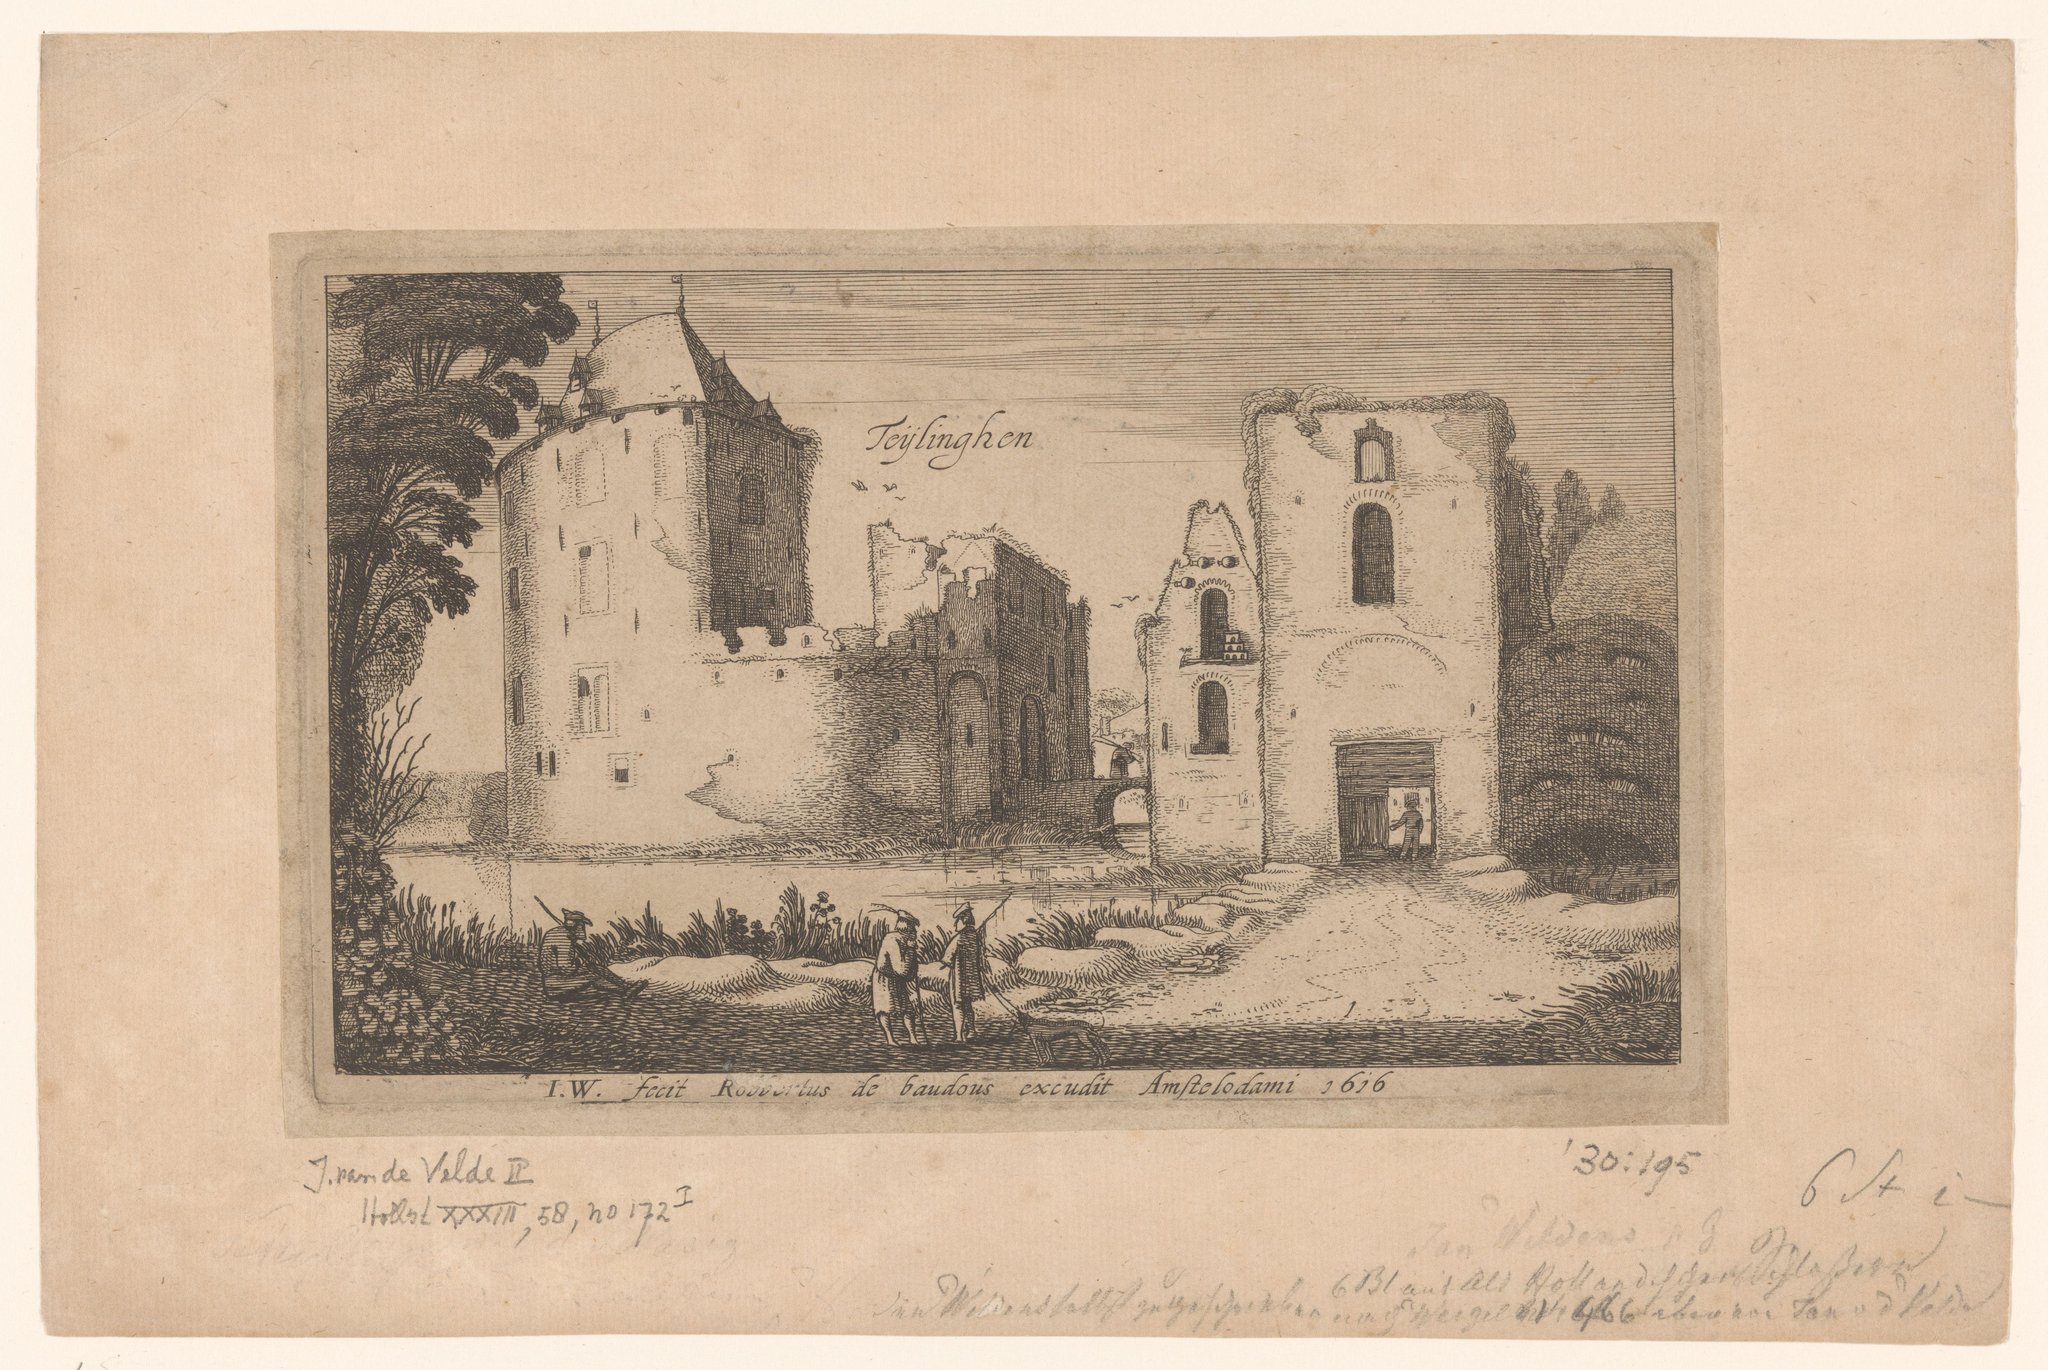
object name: print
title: Gezicht op de ruïne van Slot Teylingen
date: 1616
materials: paper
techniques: etching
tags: landscape with ruins, ruin of a dwelling, house, castle, etc.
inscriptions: collector's mark: Lugt 2233